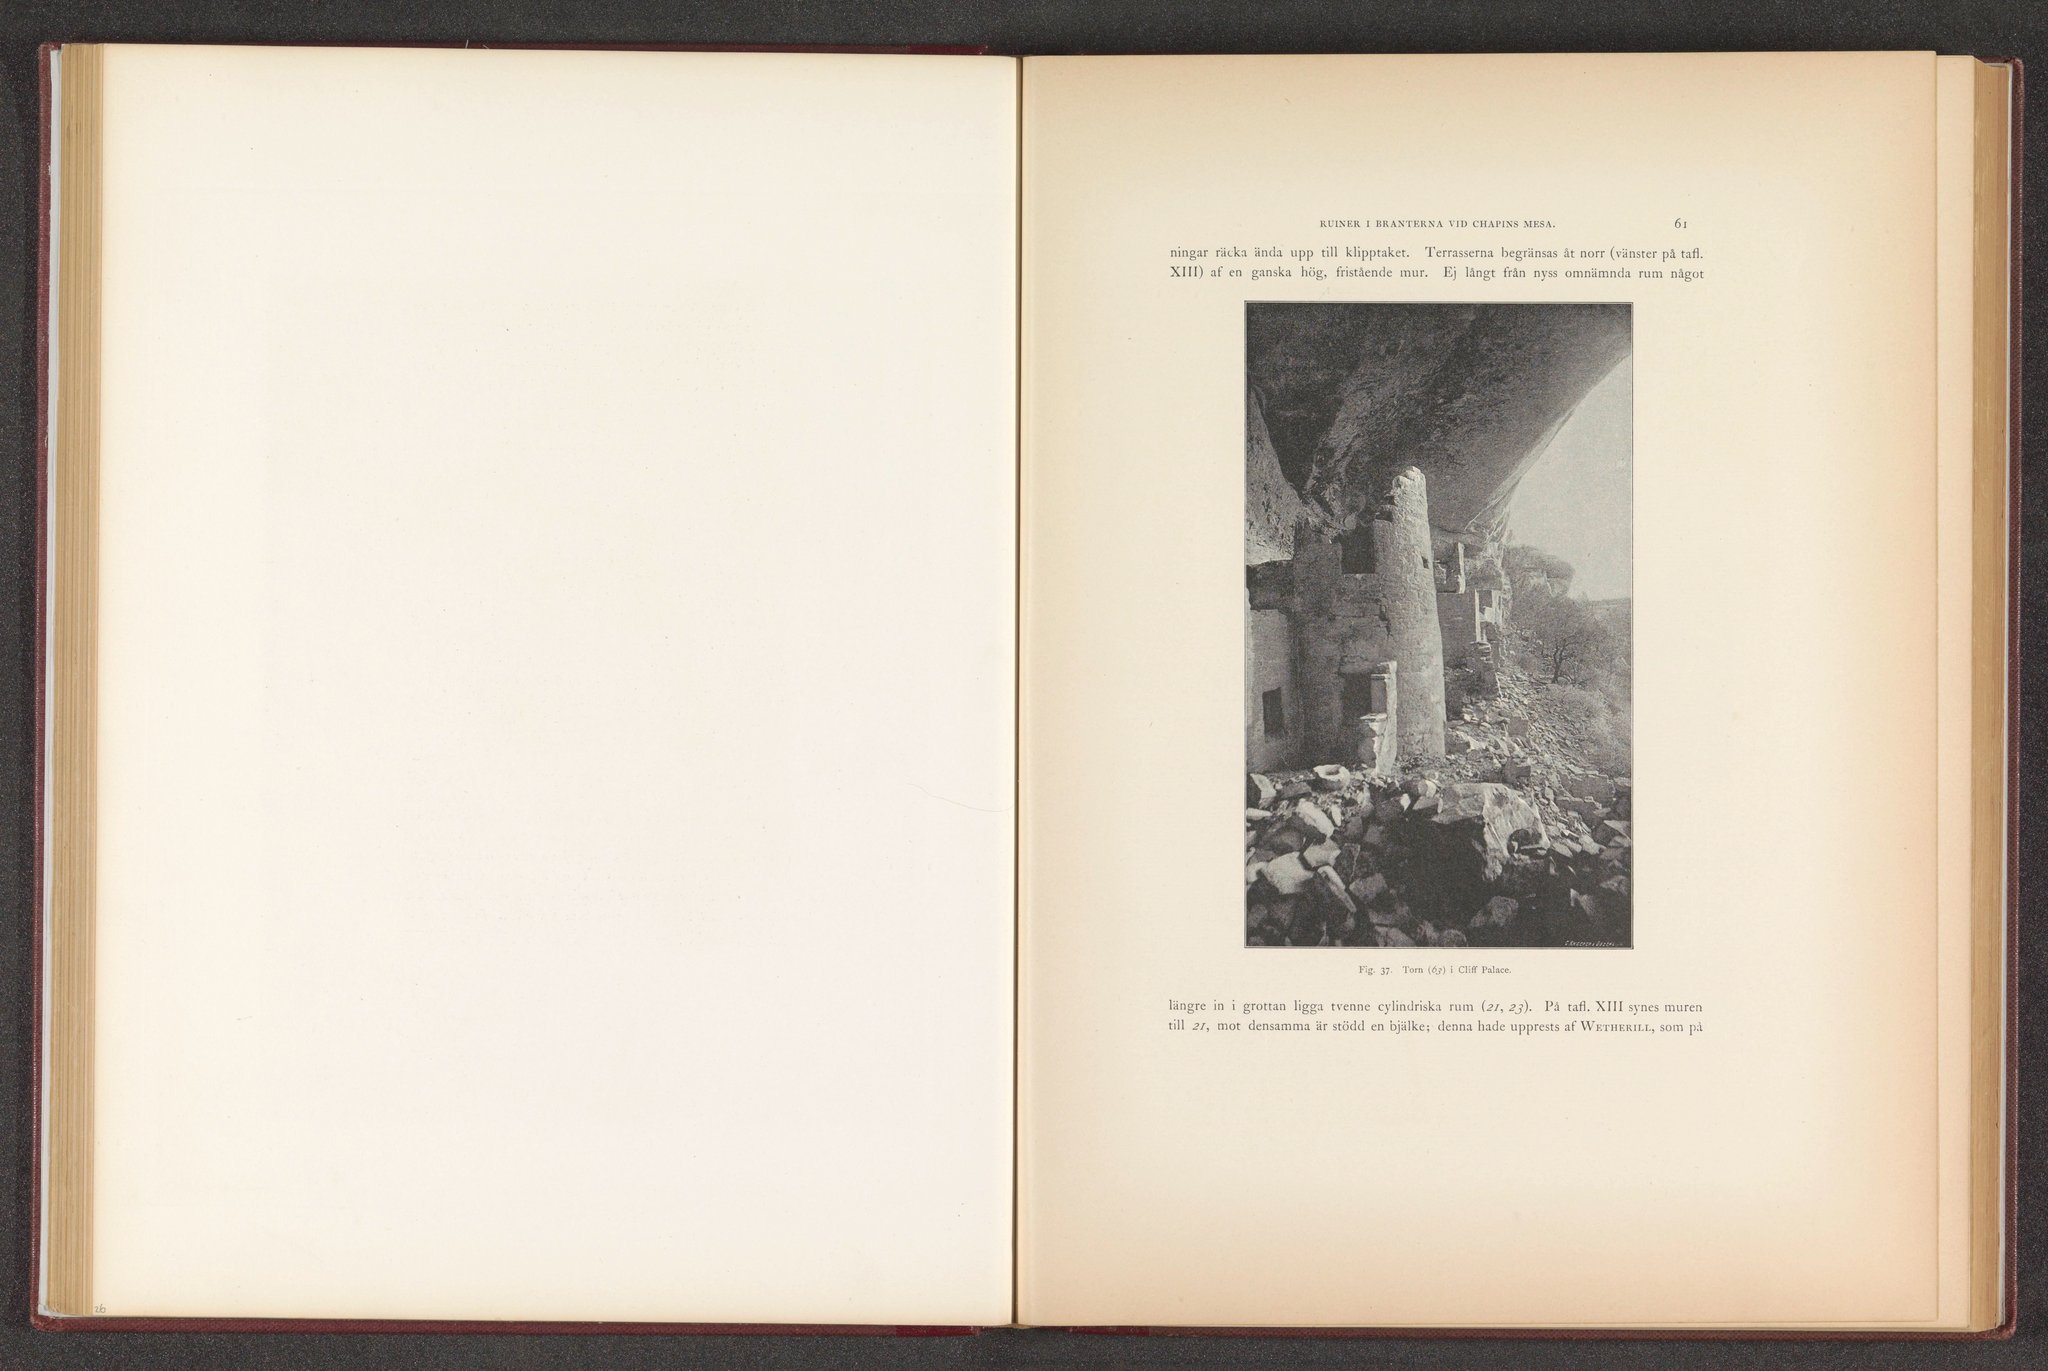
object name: photomechanical print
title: Toren in het Cliff Palace in Mesa Verde National Park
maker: gustaf nordenskiöld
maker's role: fotograaf, schrijver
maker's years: 1868-1895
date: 1891-1893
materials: paper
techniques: autotype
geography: vienna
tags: cave-dwelling, ruin of a dwelling, house, castle, etc.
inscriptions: number: ‘Fig. 37.’